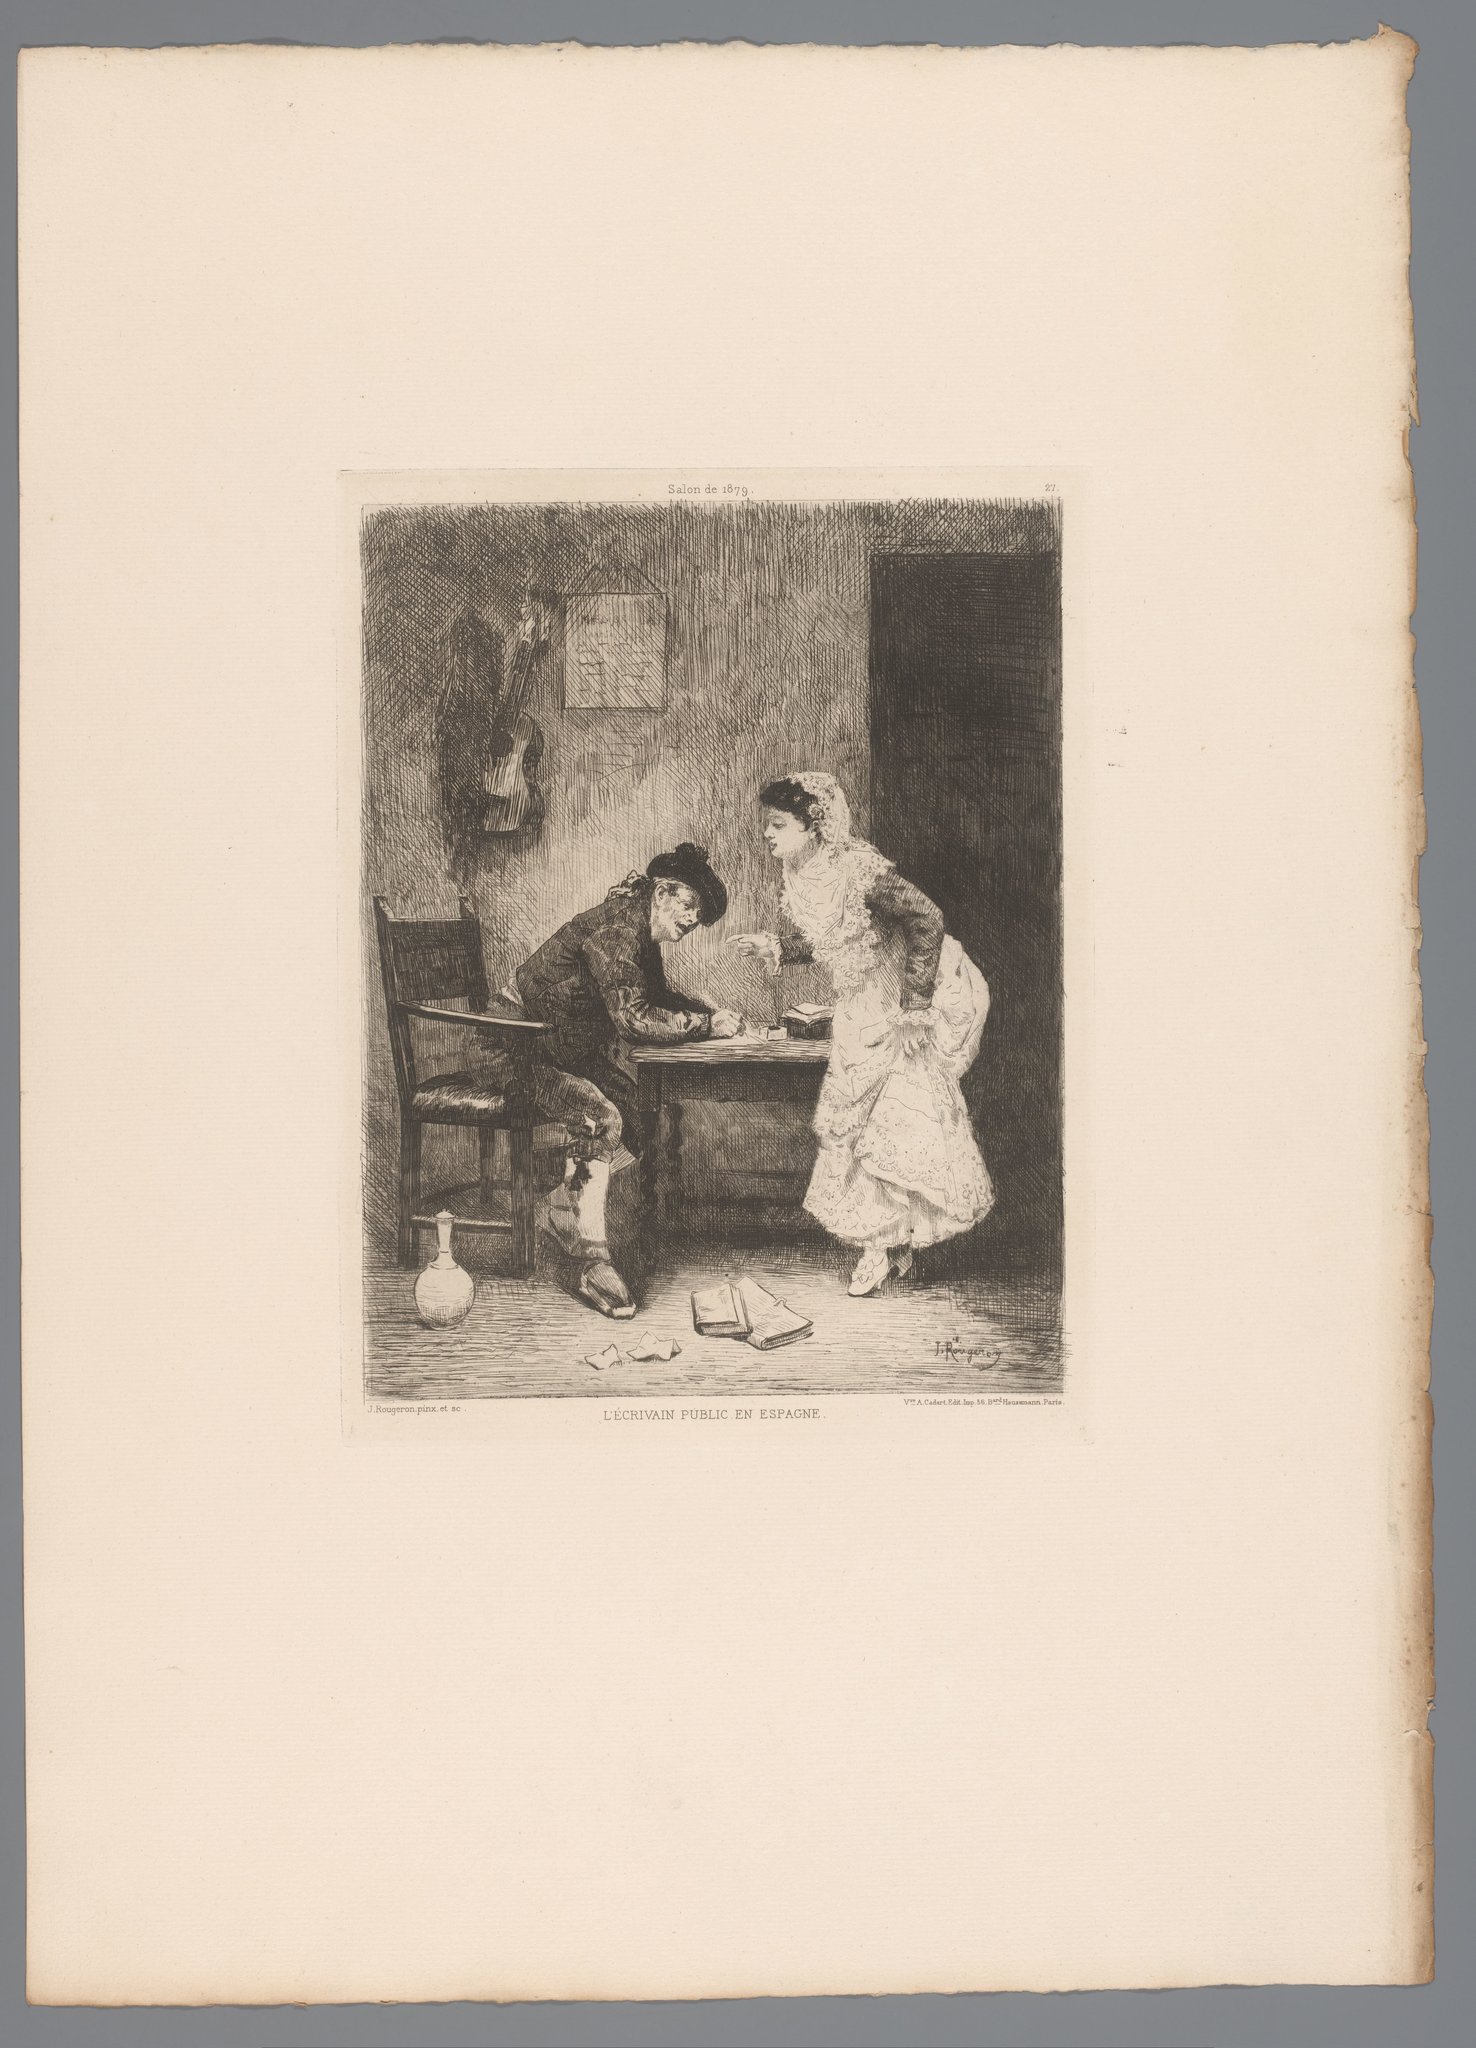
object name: print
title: Franse etsen uit 1880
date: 1880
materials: paper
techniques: drypoint, etching, intaglio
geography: paris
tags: author, poet dictating, writing and letters, spain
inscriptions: collector's mark: Lugt 2228, collector's mark: ‘AFE v S’, collector's mark: Lugt 2760, watermark